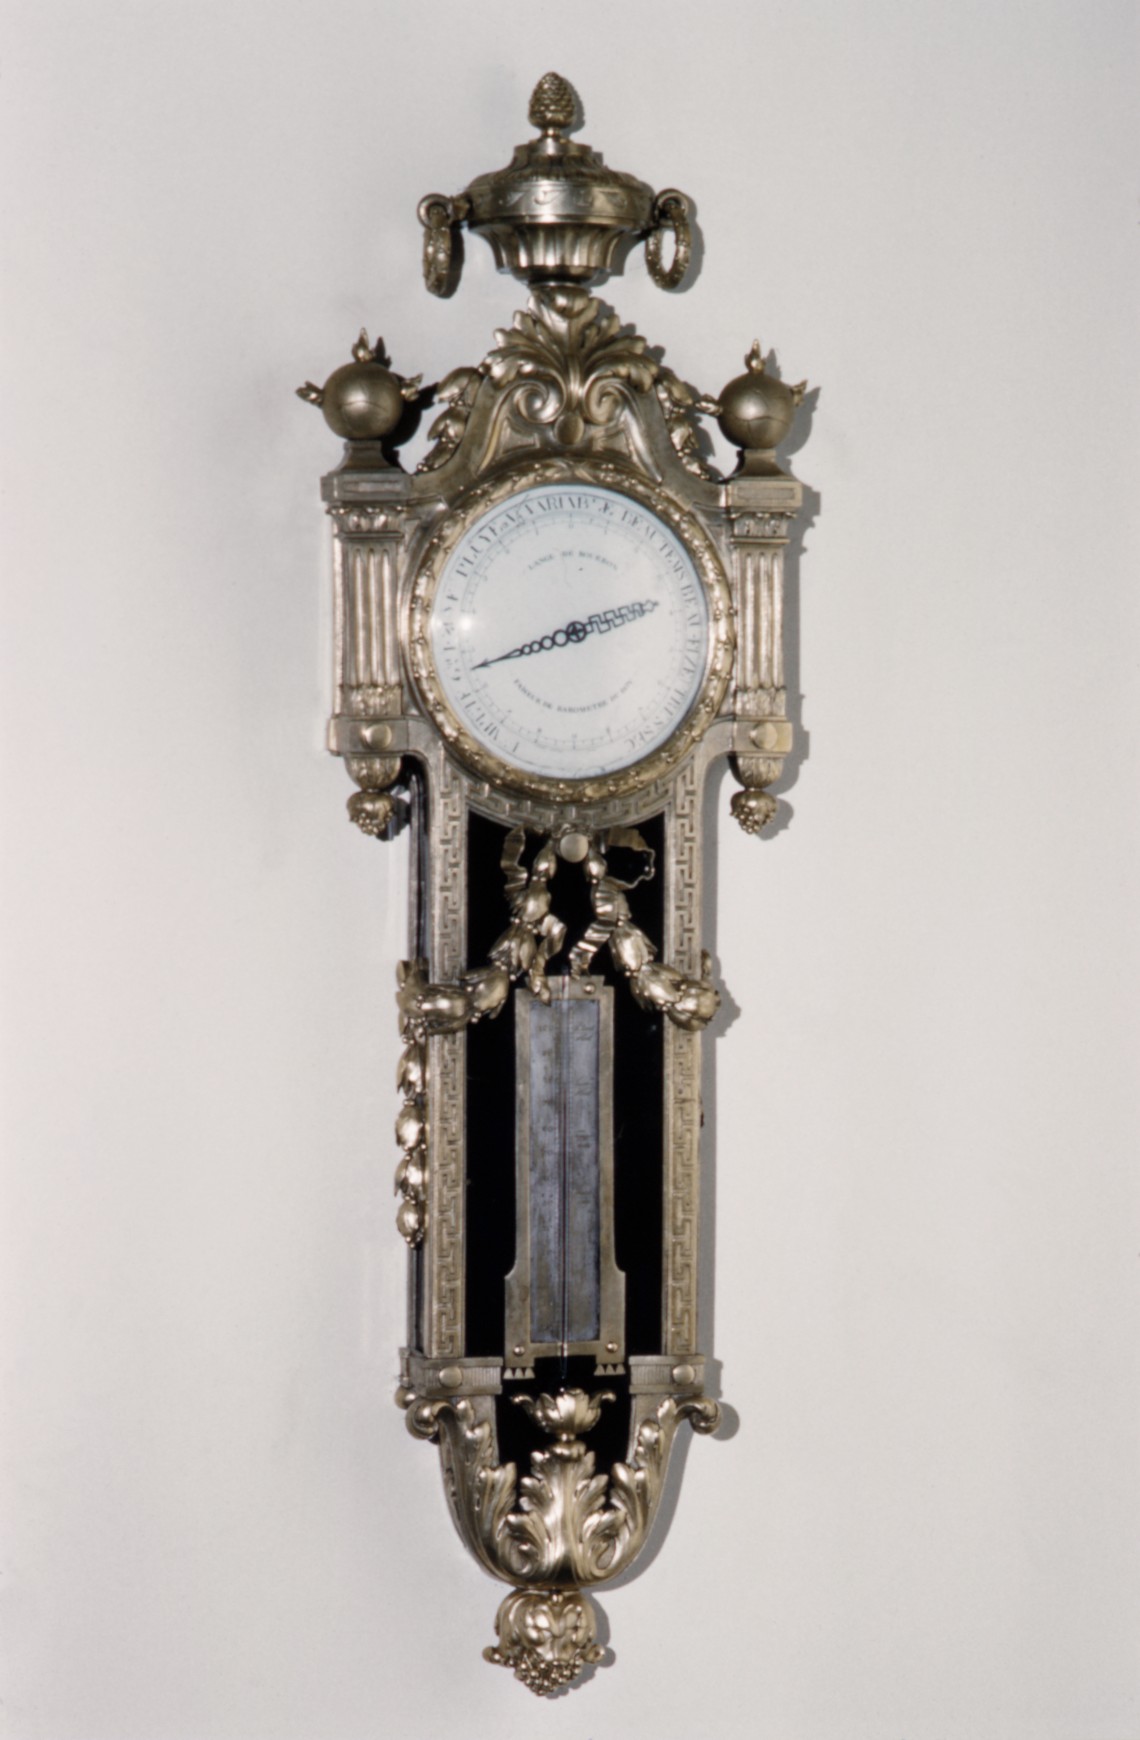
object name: wall clock barometer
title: Wall clock-barometer (baromètre et thermomètre en cartel)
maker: lange de bourbon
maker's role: maker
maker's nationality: french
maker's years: 1750-1775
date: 1770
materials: gilt bronze, wood, steel, shell